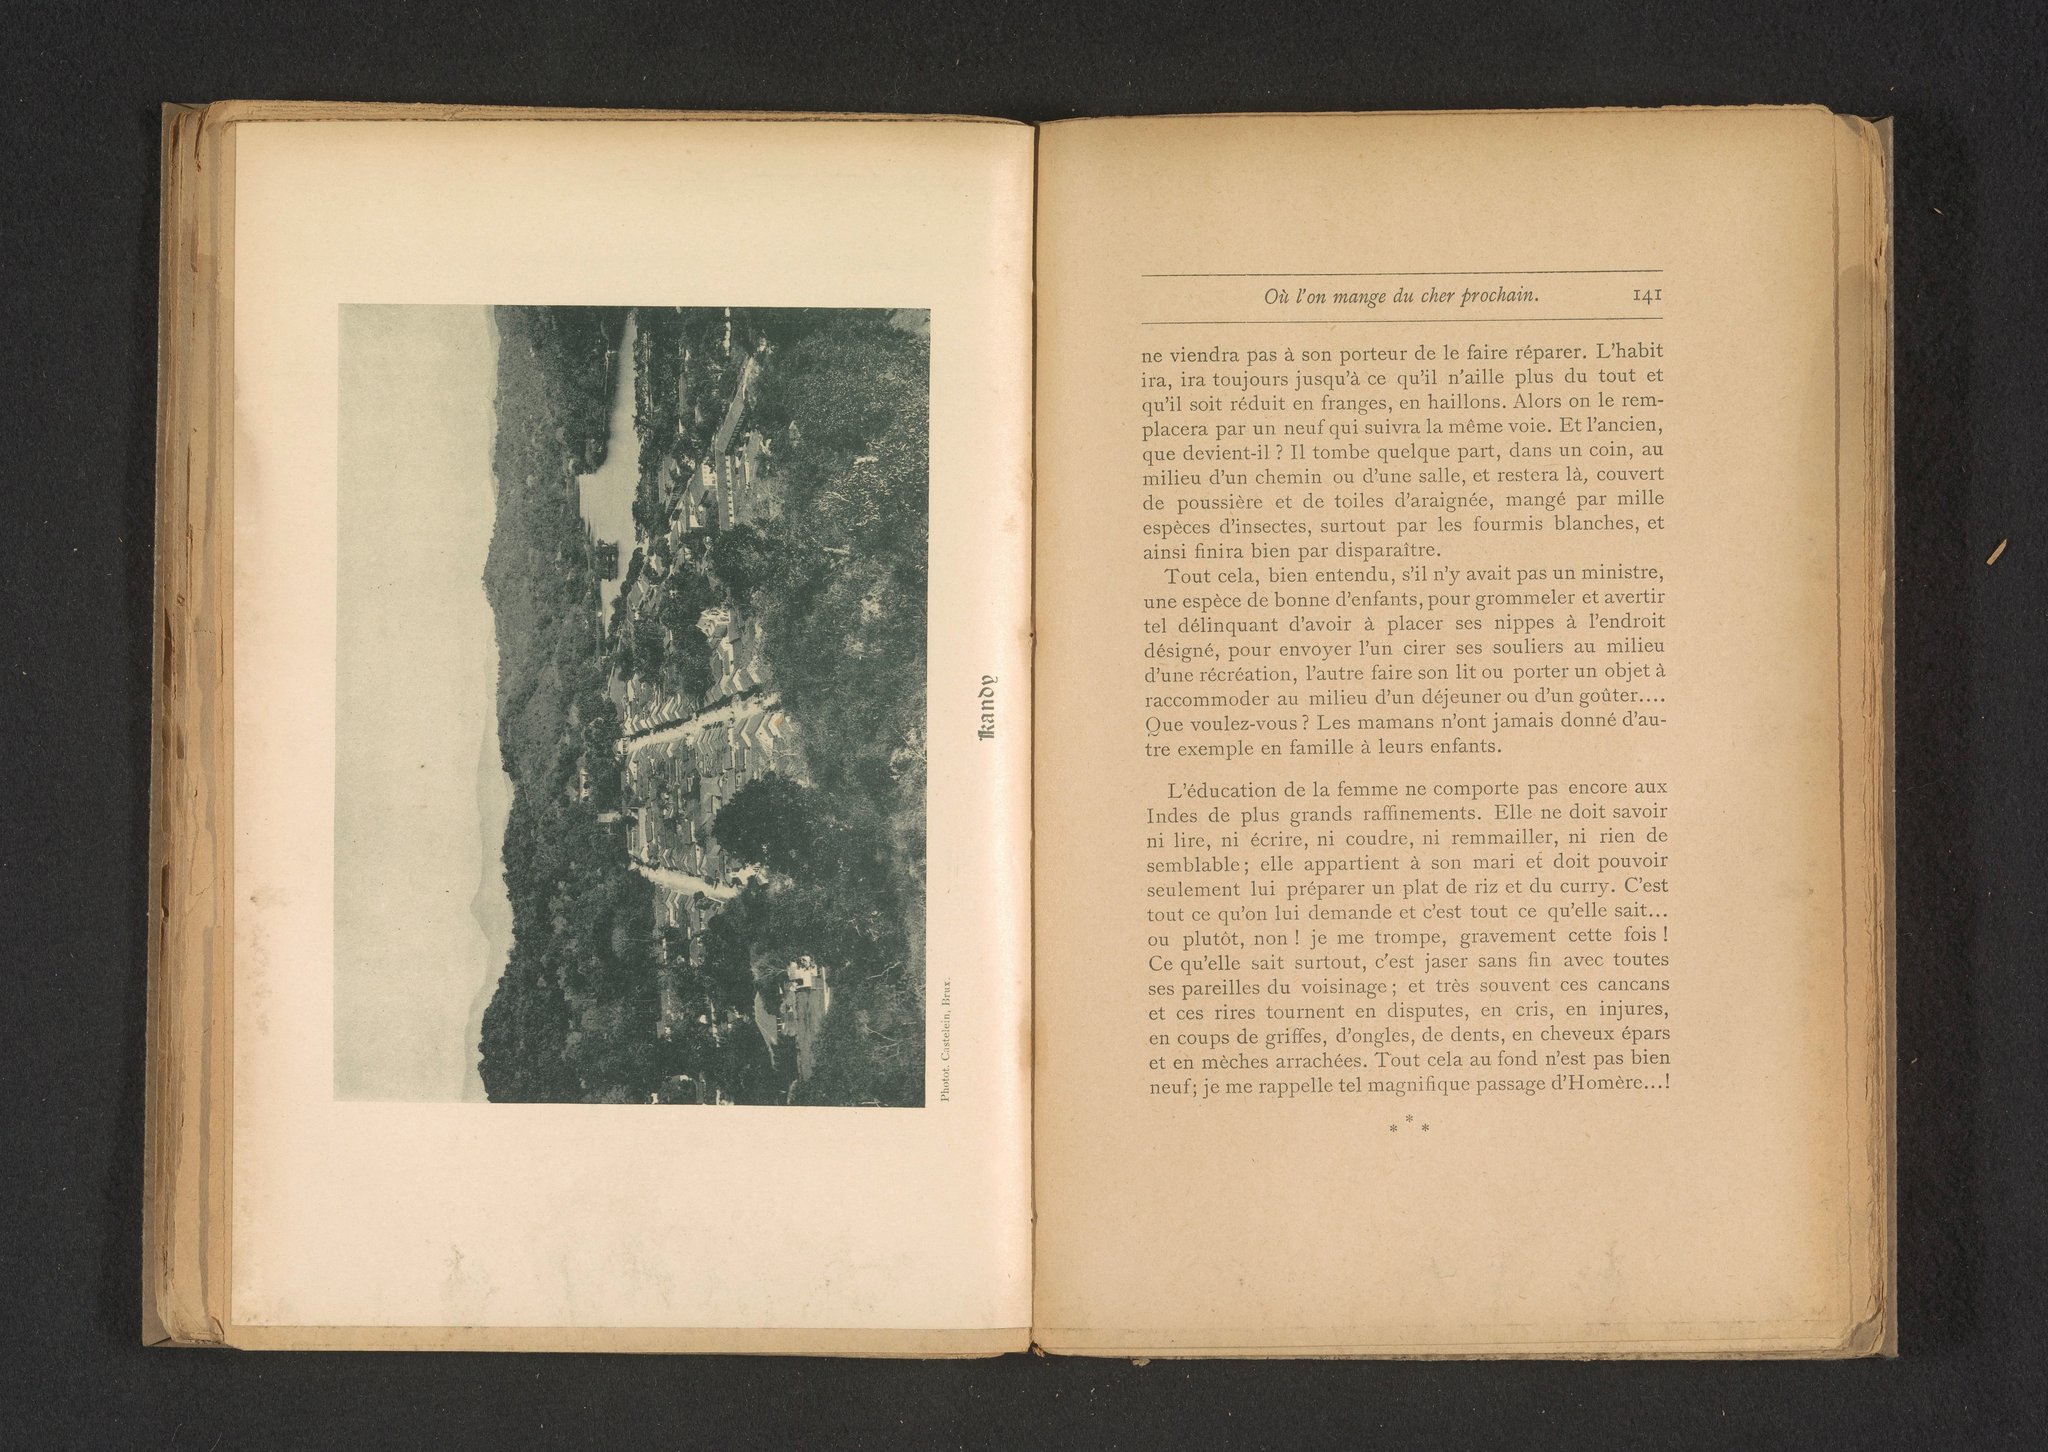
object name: photomechanical print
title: Gezicht op Kandy, Sri Lanka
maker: e. castelein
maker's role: printer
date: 1894-1899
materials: paper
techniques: photograph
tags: prospect of city, town panorama, silhouette of city